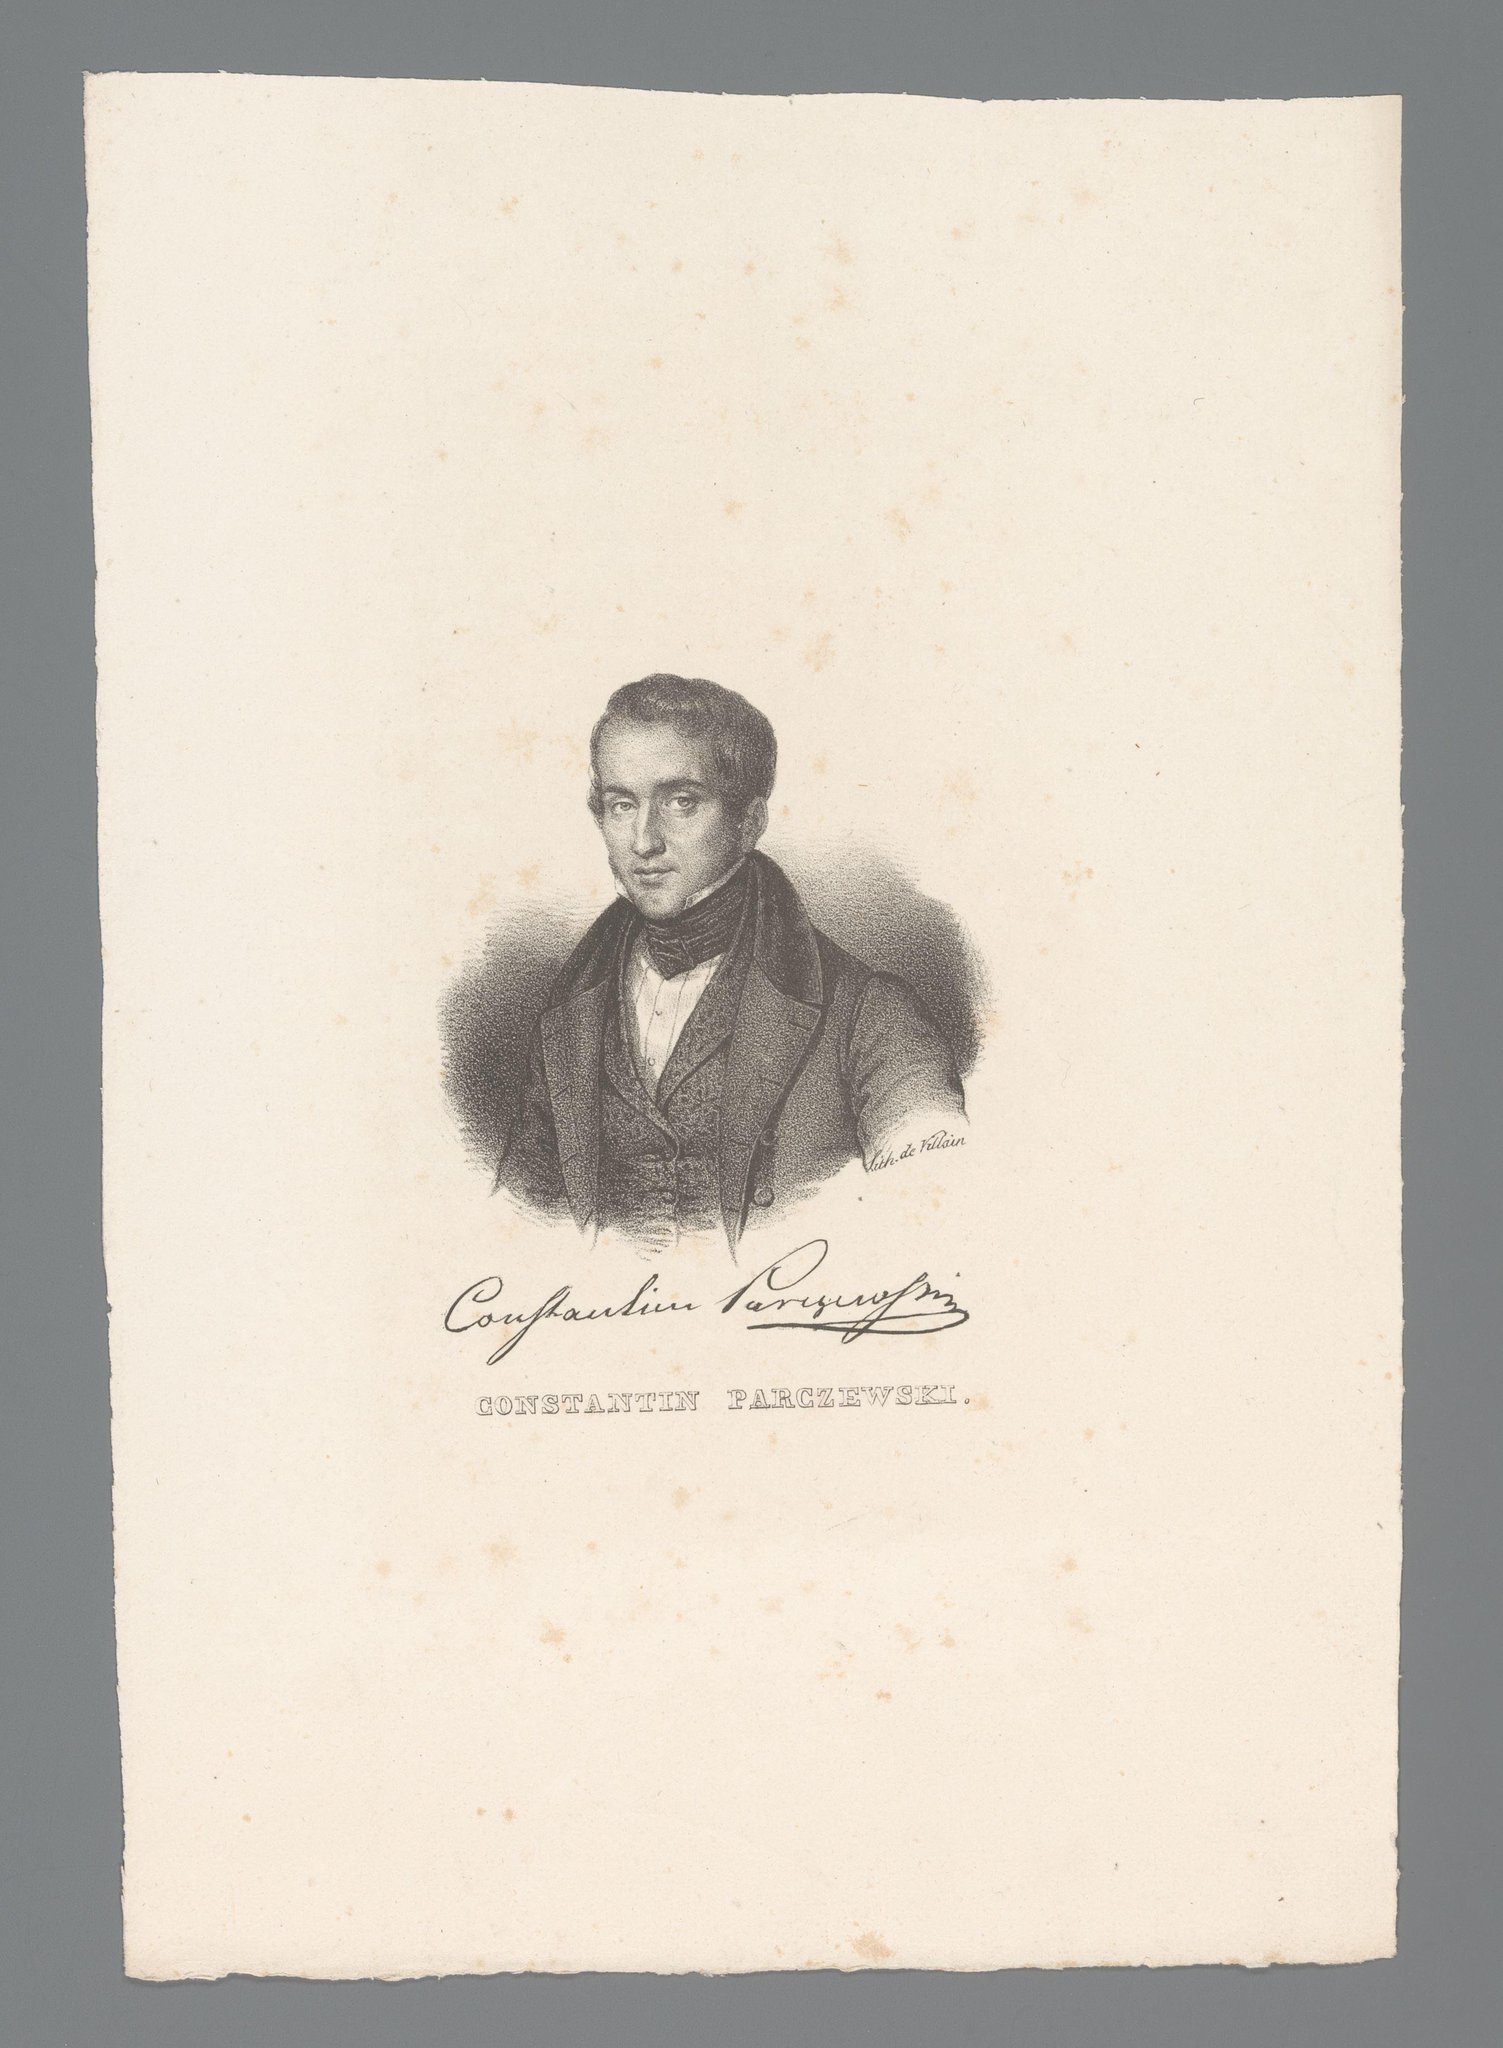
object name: print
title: Constantin Parczewski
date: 1832-1839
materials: paper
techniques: lithograph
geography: paris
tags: historical persons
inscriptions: collector's mark: Lugt 2228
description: Prent uit: Straszewicz., Joseph. Les polonais et les polonaises de la révolution du 29 novembre 1830, ou Portraits des personnes qui ont figuré dans la dernière guerre de l'indépendance polonaise, avec les fac-simile de leur signature, lithographiés sur dessins originaux, par les artistes les plus distingués: MM. Grévedon, Maurin, Vigneron, Belliard, Devéria, Bazin, Desmadryl, Lecler, Desmaisons, Rutowski, officier polonais, etc,. etc., accompagnés d'une biographie pour chaque portrait. Parijs: Catherine-Anaïs Pinard, 1832. Of uit: Straszewicz., Joseph. Les polonais et les polonaises de la révolution du 29 novembre 1830. Biographie des personnes qui ont figuré dans la dernière guerre de l'indépendance polonaise, avec les fac-simile de leur signature, ornée de 30 portraits lithographiés sur dessins originaux, par les artistes les plus distingués: MM. Grévedon, Maurin, Vigneron, Belliard, Devéria, Bazin, Desmadryl, Lecler, etc., etc.. Parijs: s.n., 1839.